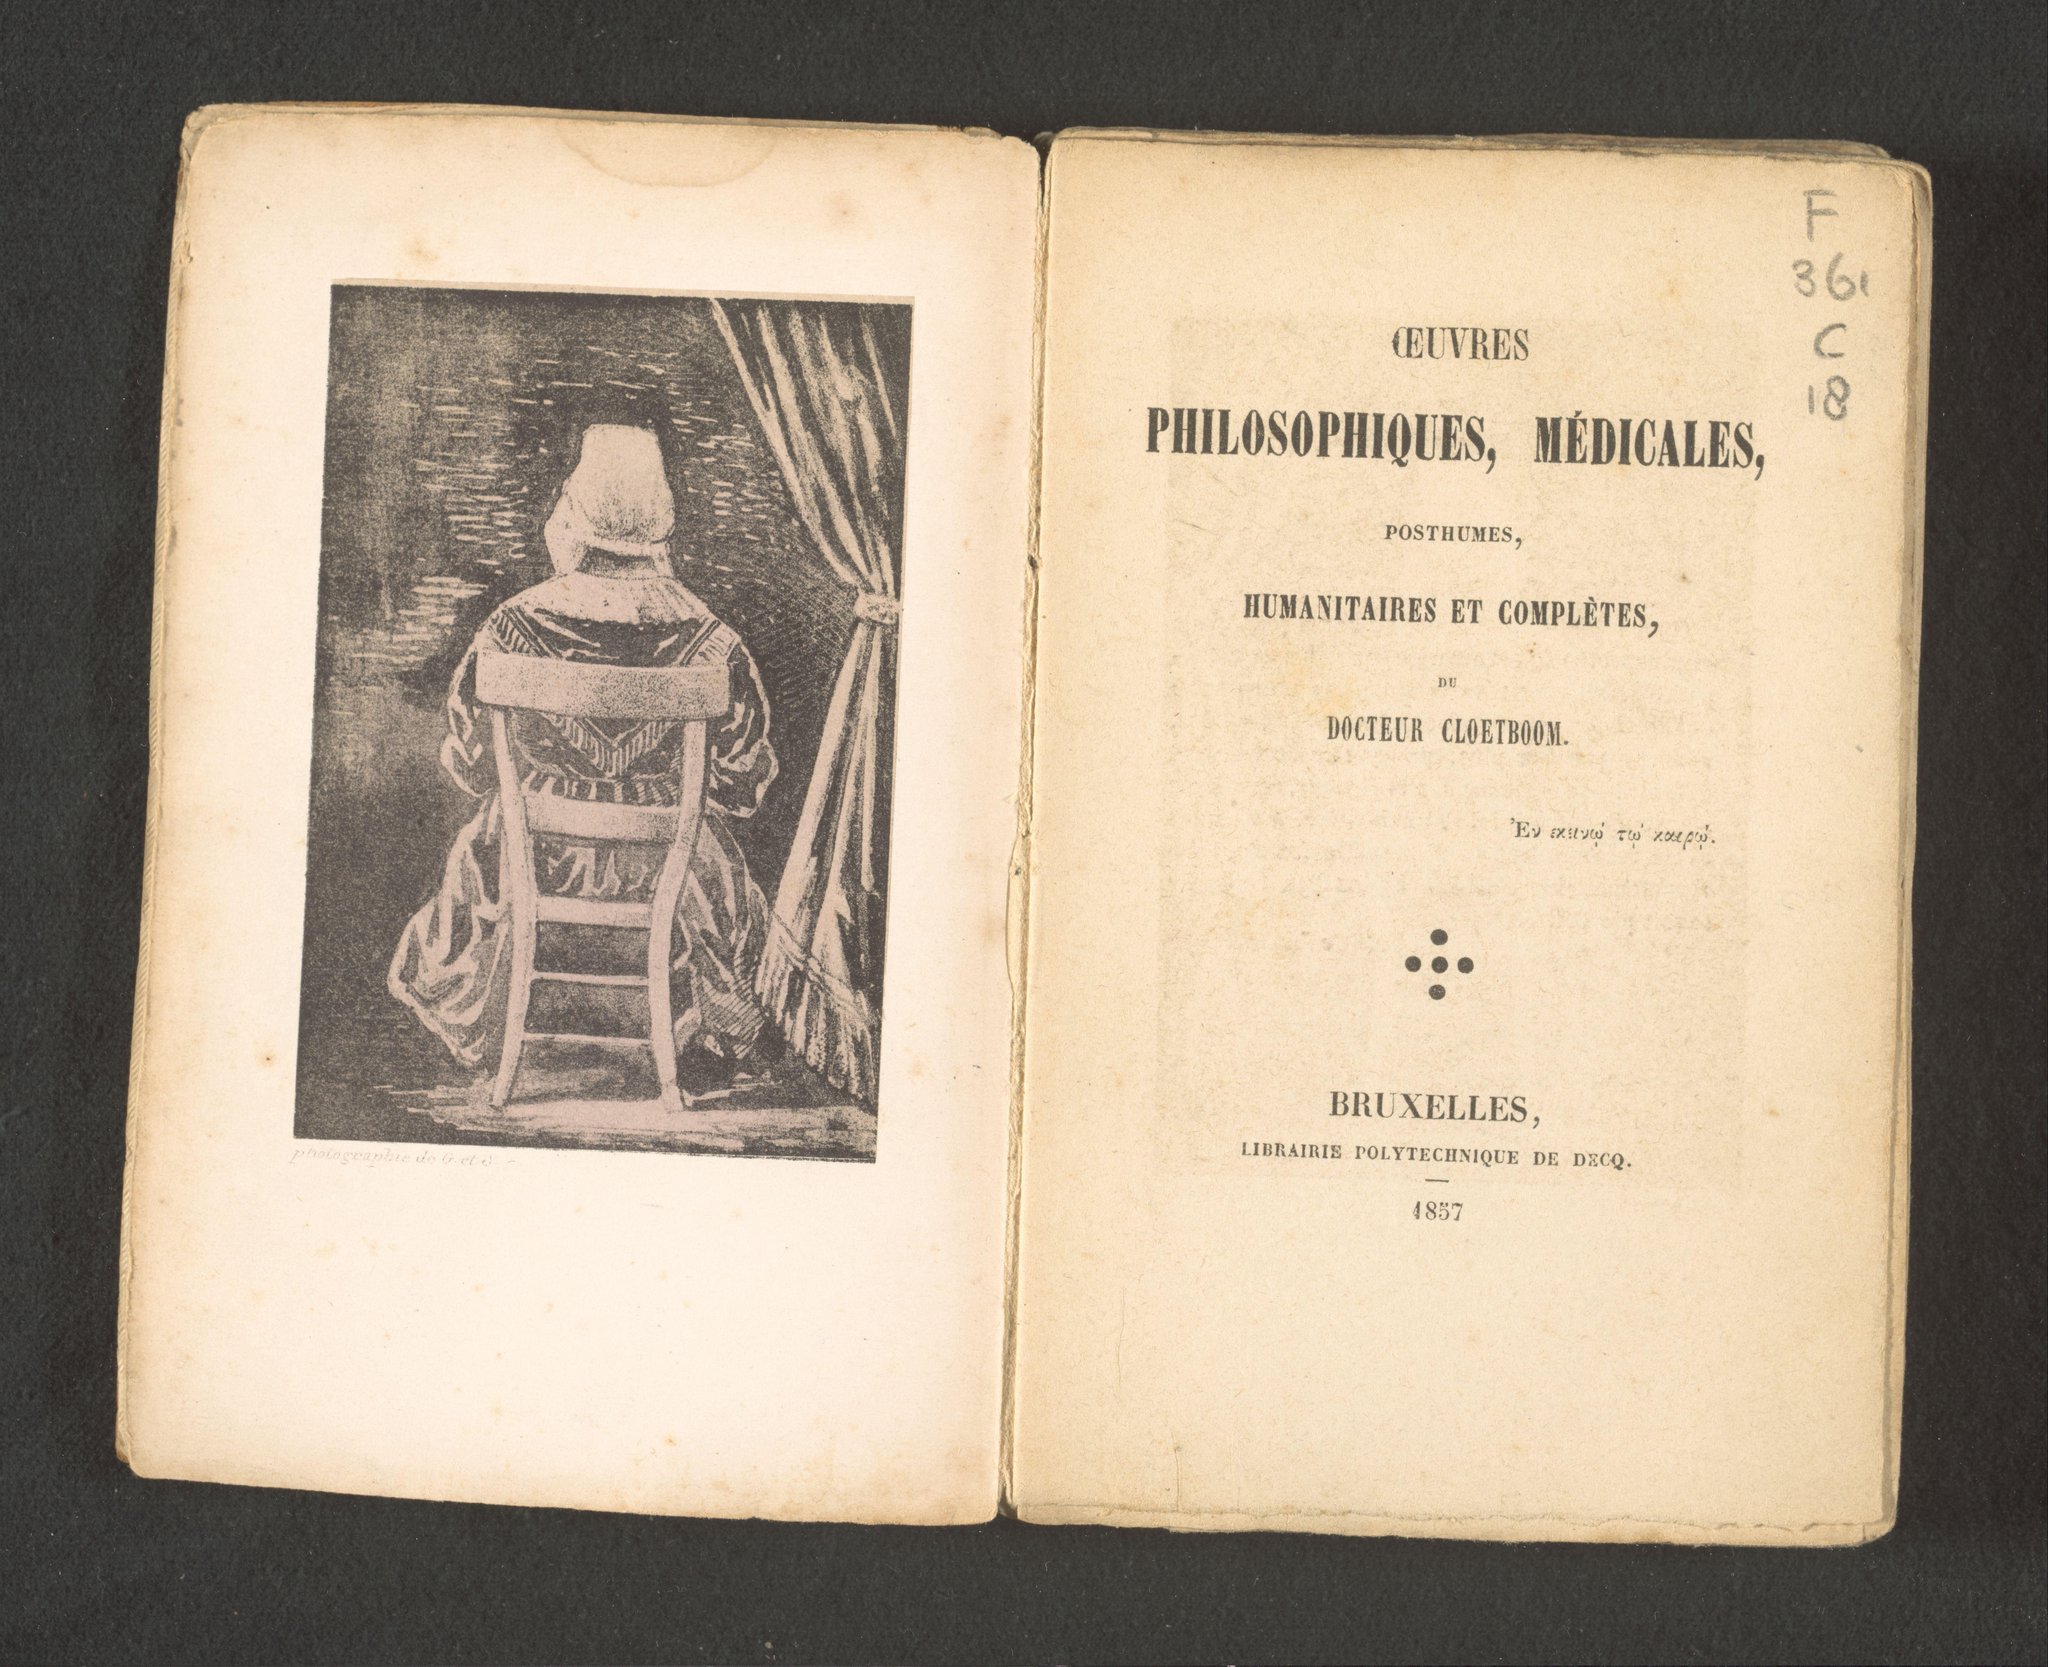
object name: reproduction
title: Reproductie van een ontwerp van een vrouw op een stoel, op de rug gezien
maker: Anonymous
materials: paper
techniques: photolithography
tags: adult woman (+ back view), chair